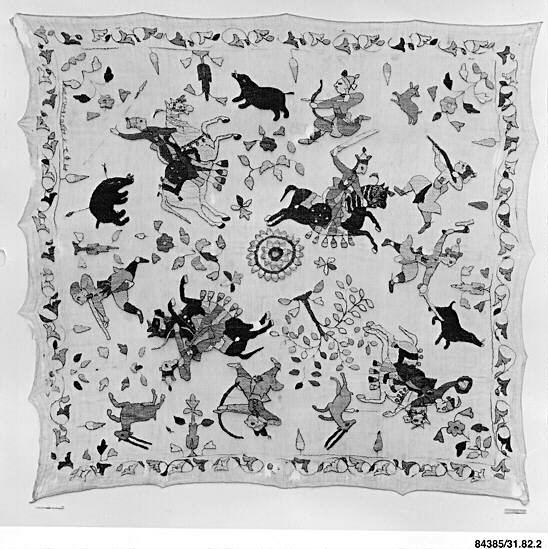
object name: cover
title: Cover (Rumal)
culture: indian, himachal pradesh, chamba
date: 1701-1800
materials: cotton, metal, silk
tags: hunting,deer,horses,pigs,flowers